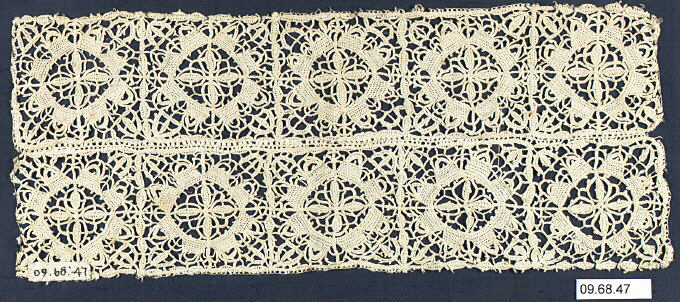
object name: piece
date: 1600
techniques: lace